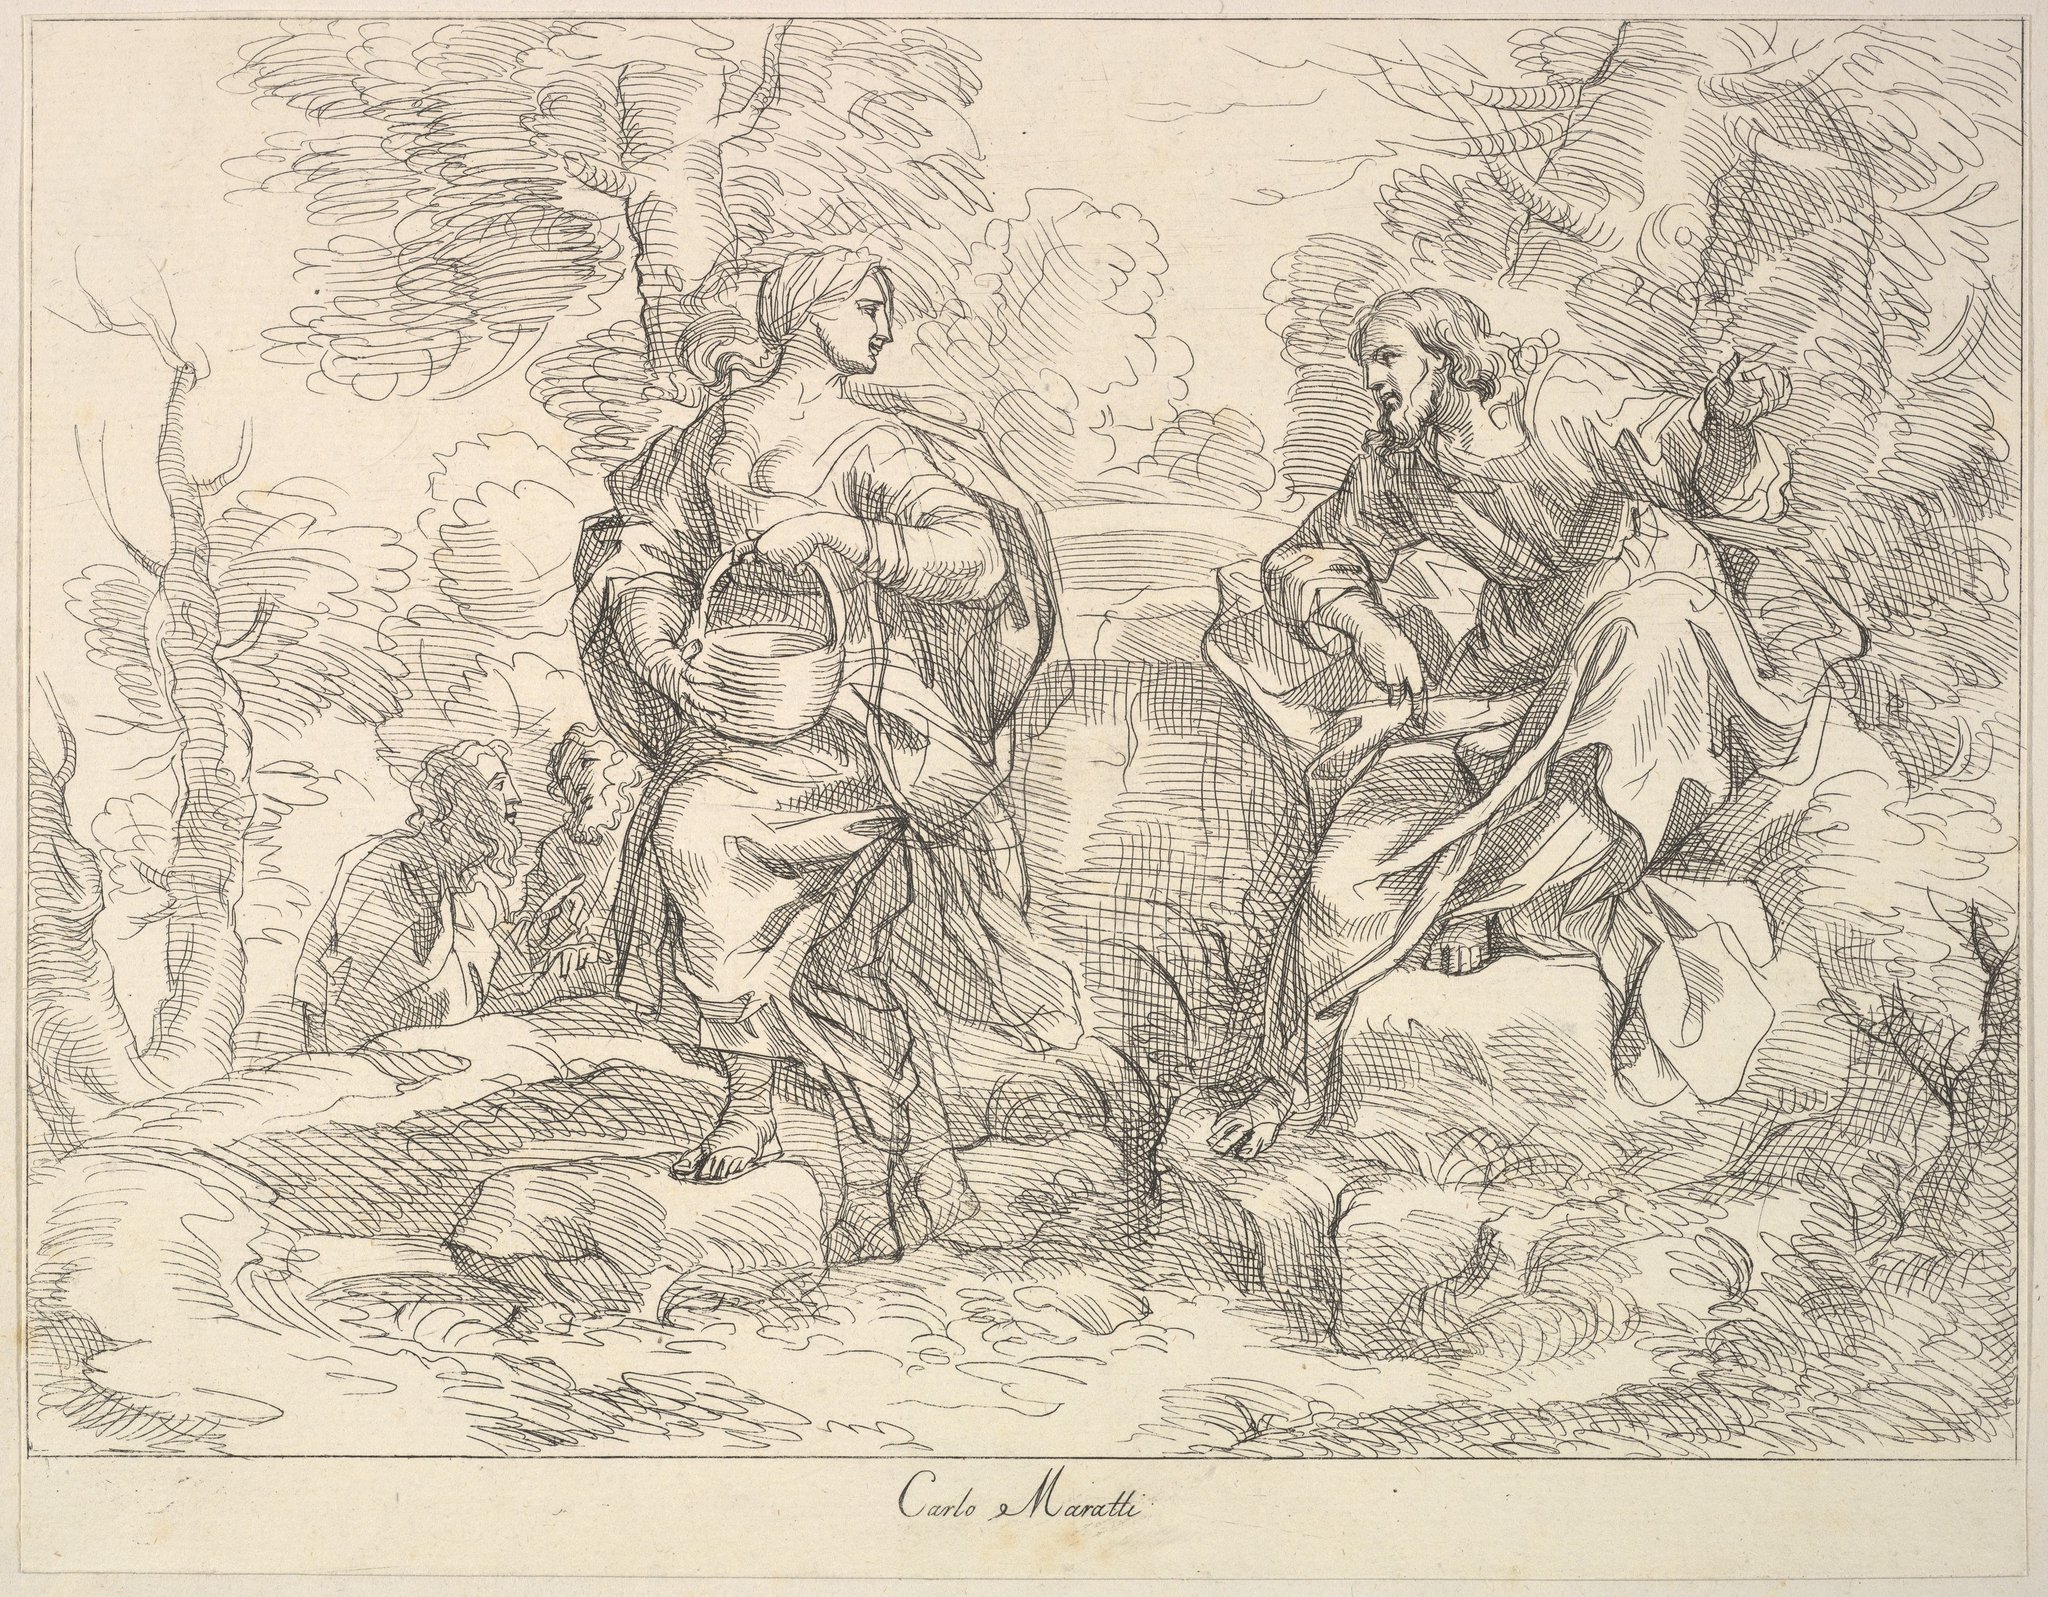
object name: print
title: Christ appearing to Mary Magdalen(?)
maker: giuseppe canale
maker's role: artist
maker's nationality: italian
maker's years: 1725-1802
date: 1740-1802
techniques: etching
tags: christ,mary magdalene